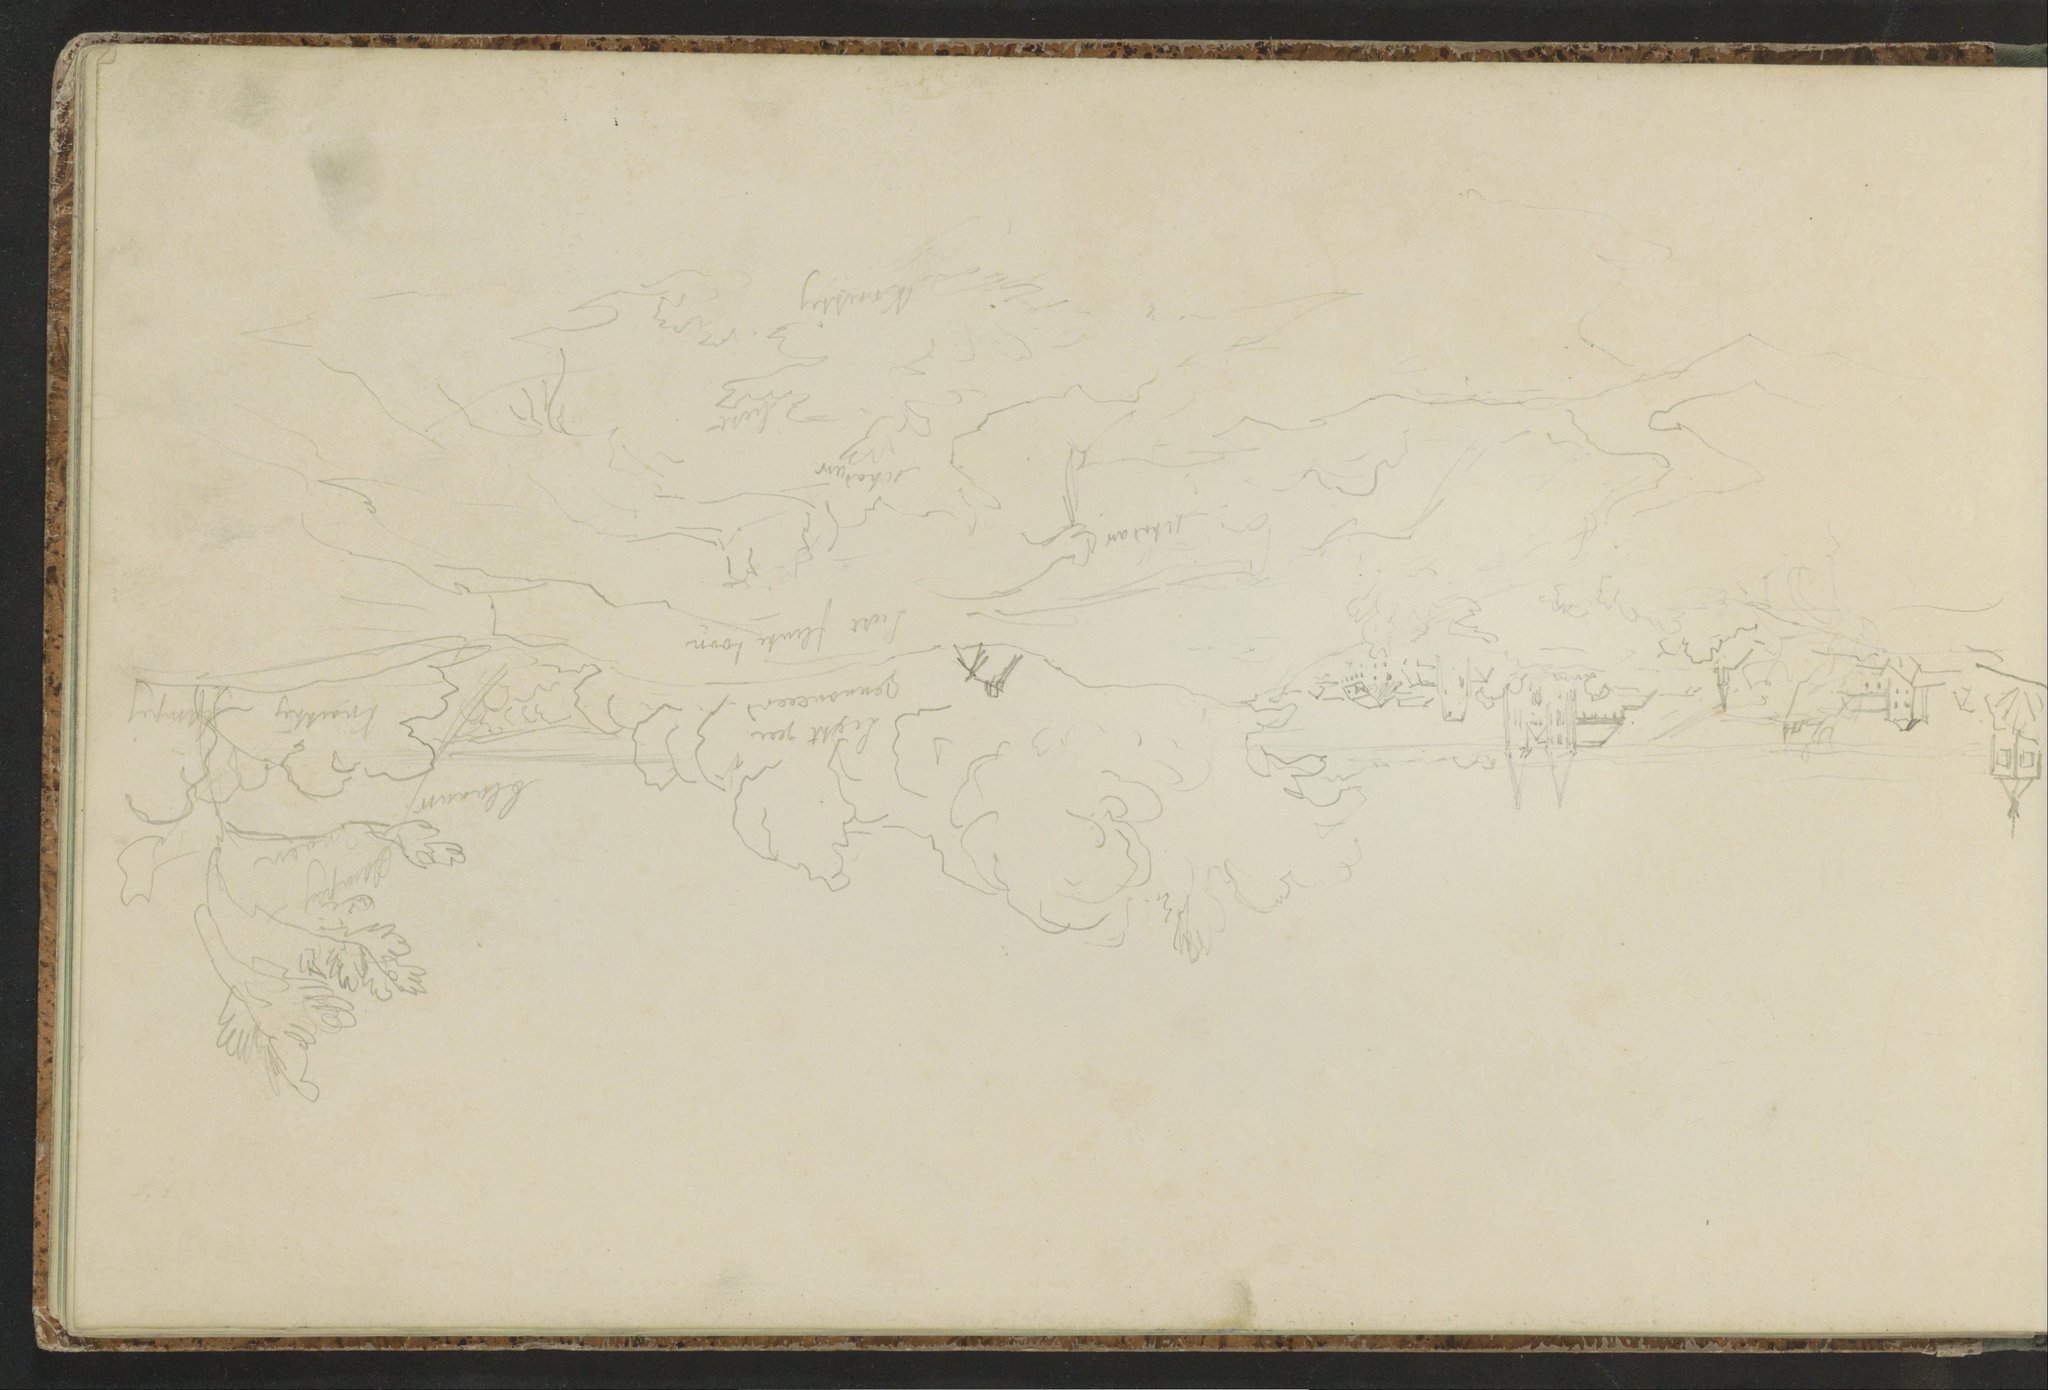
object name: sketchbook leaf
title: Gezicht op een stad in een heuvellandschap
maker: johannes tavenraat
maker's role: draughtsman, painter, print maker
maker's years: 1809-1881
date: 1840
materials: paper, pencil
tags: city-view, and landscape with man-made constructions, low hill country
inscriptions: kleurnotitie, handgeschreven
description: Blad 22 verso uit een schetsboek met 33 bladen.